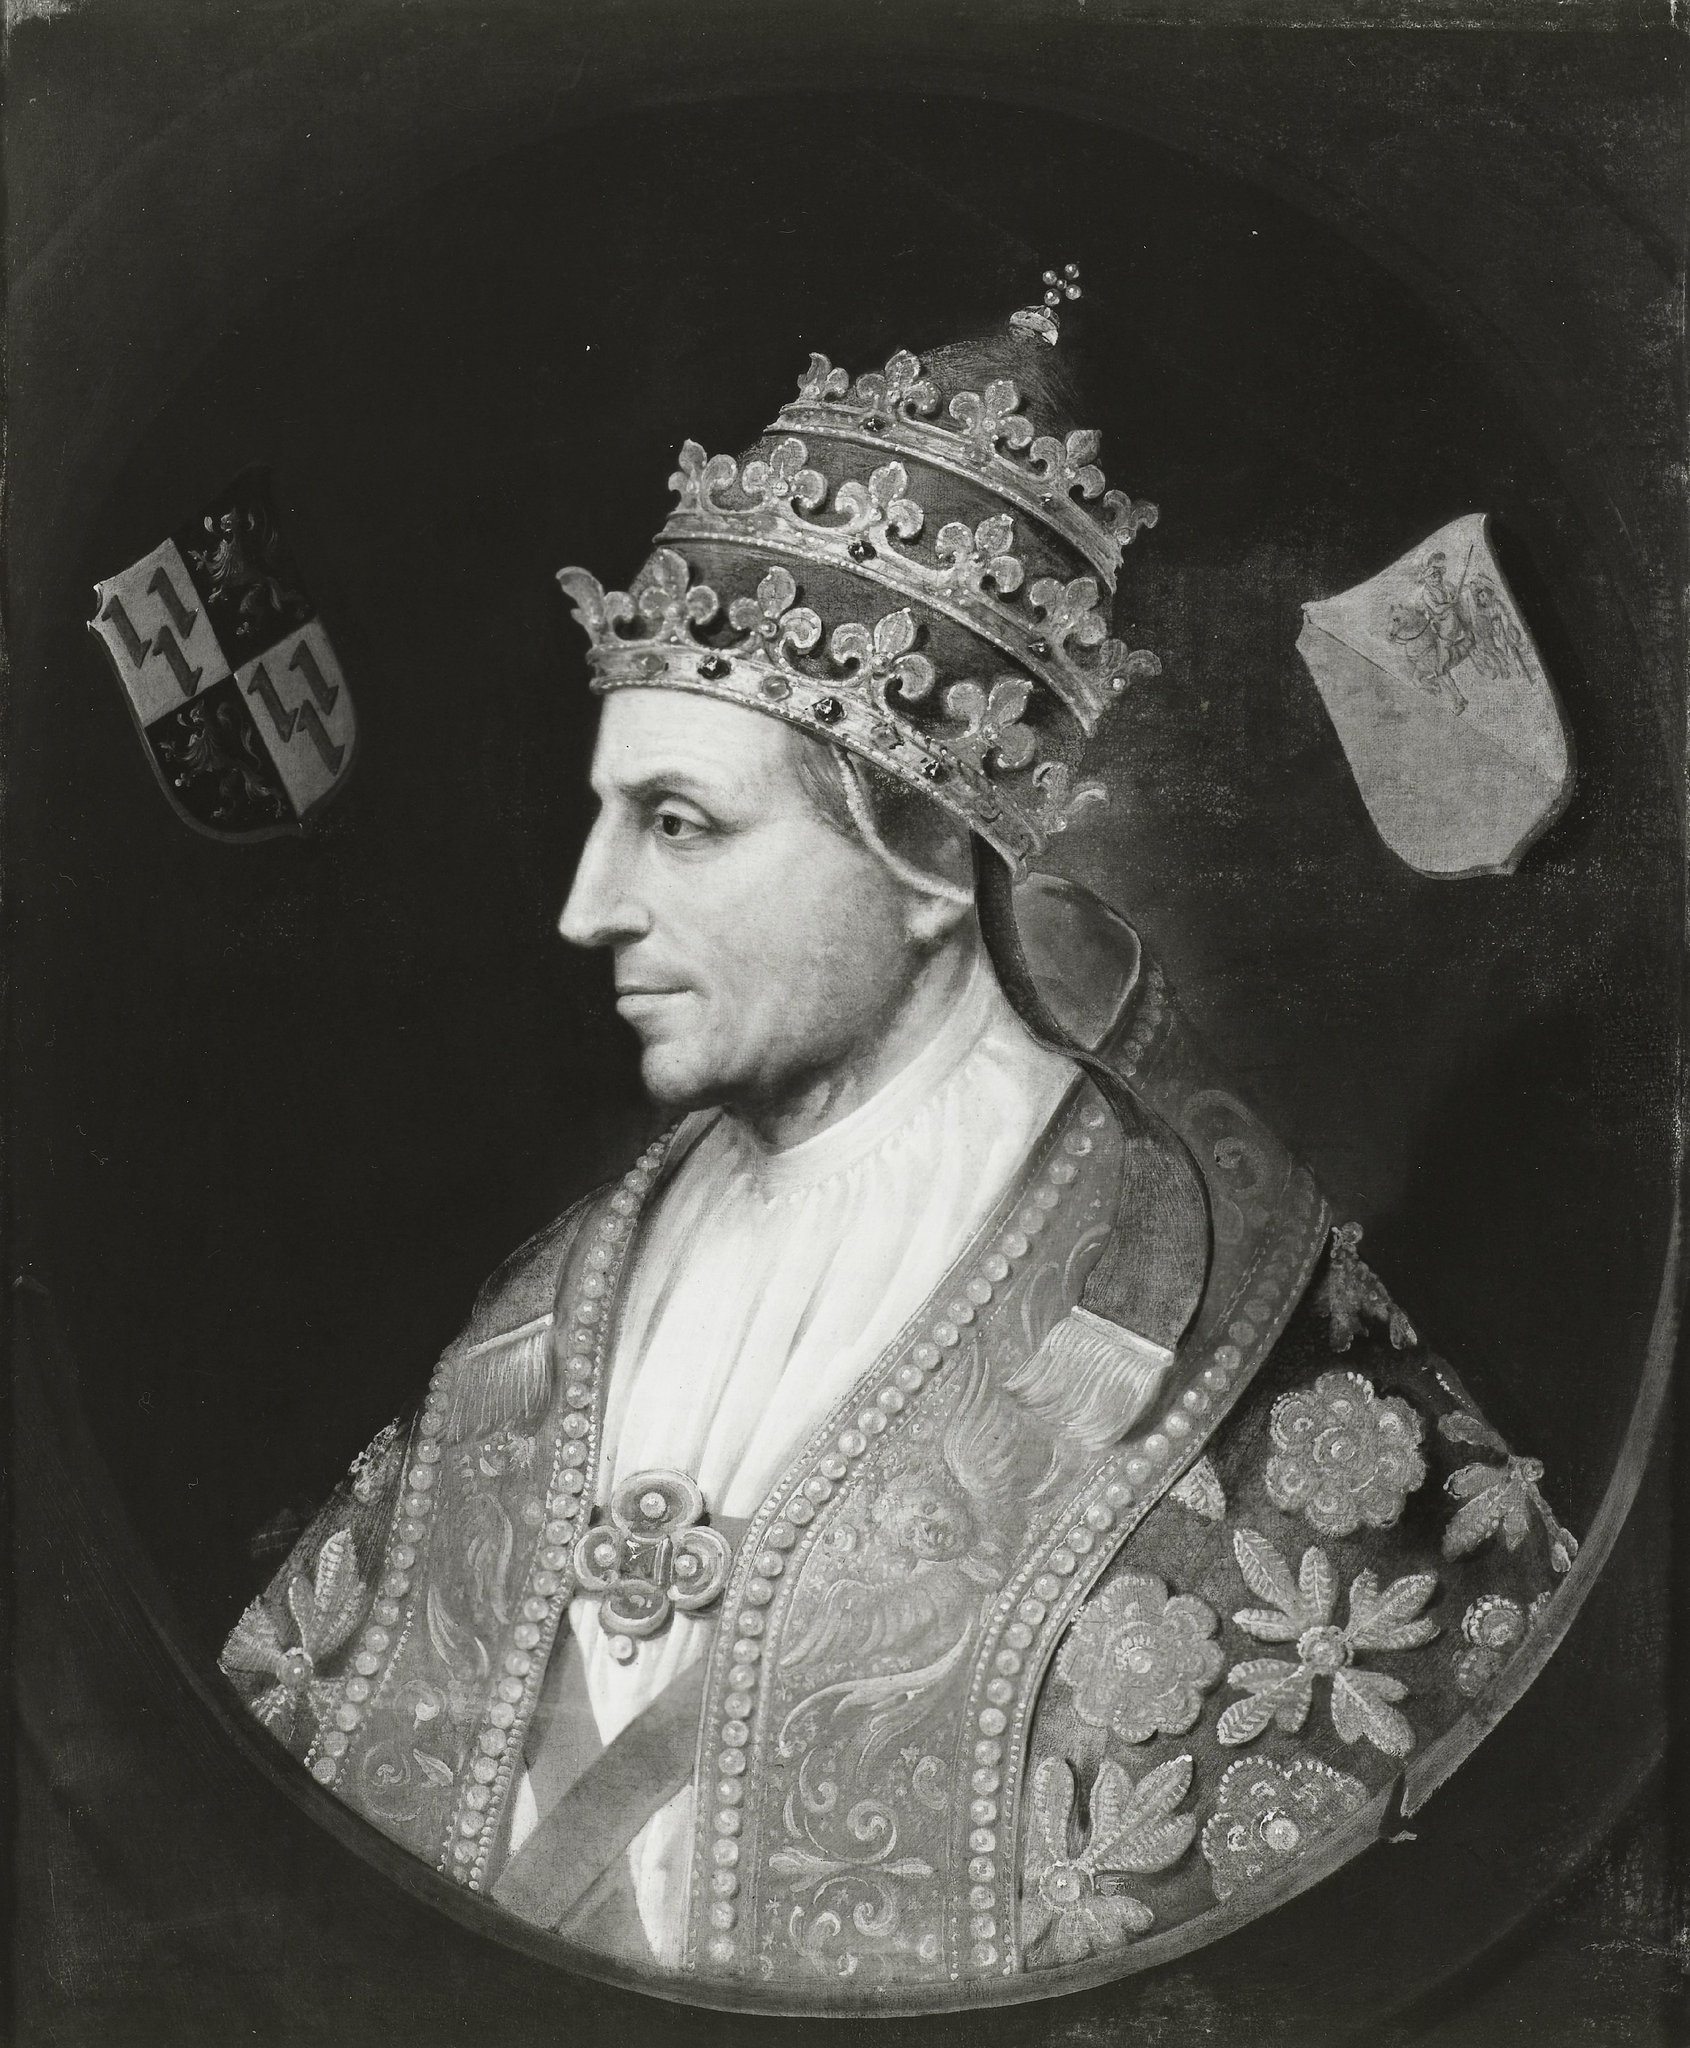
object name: painting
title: Pope Adrian VI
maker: Anonymous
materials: canvas, oil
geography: northern netherlands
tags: utrecht, rome, clergyman, historical persons, pope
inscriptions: coat of arms, upper right: divided diagonally, 1, a plain field; 2, St Martin on horseback dividing his cloak with a beggar; tinctures unknown, coat of arms, upper left: 1 and 4, three crampons, two above one; 2 and 3, a lion rampant; tinctures unknown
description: Portret van paus Adrianus VI (1459-1523). Buste in ovaal naar links, met tiara en rijk bewerkte mantel; links en rechts familiewapens. Kopie naar een origineel uit ca. 1520.